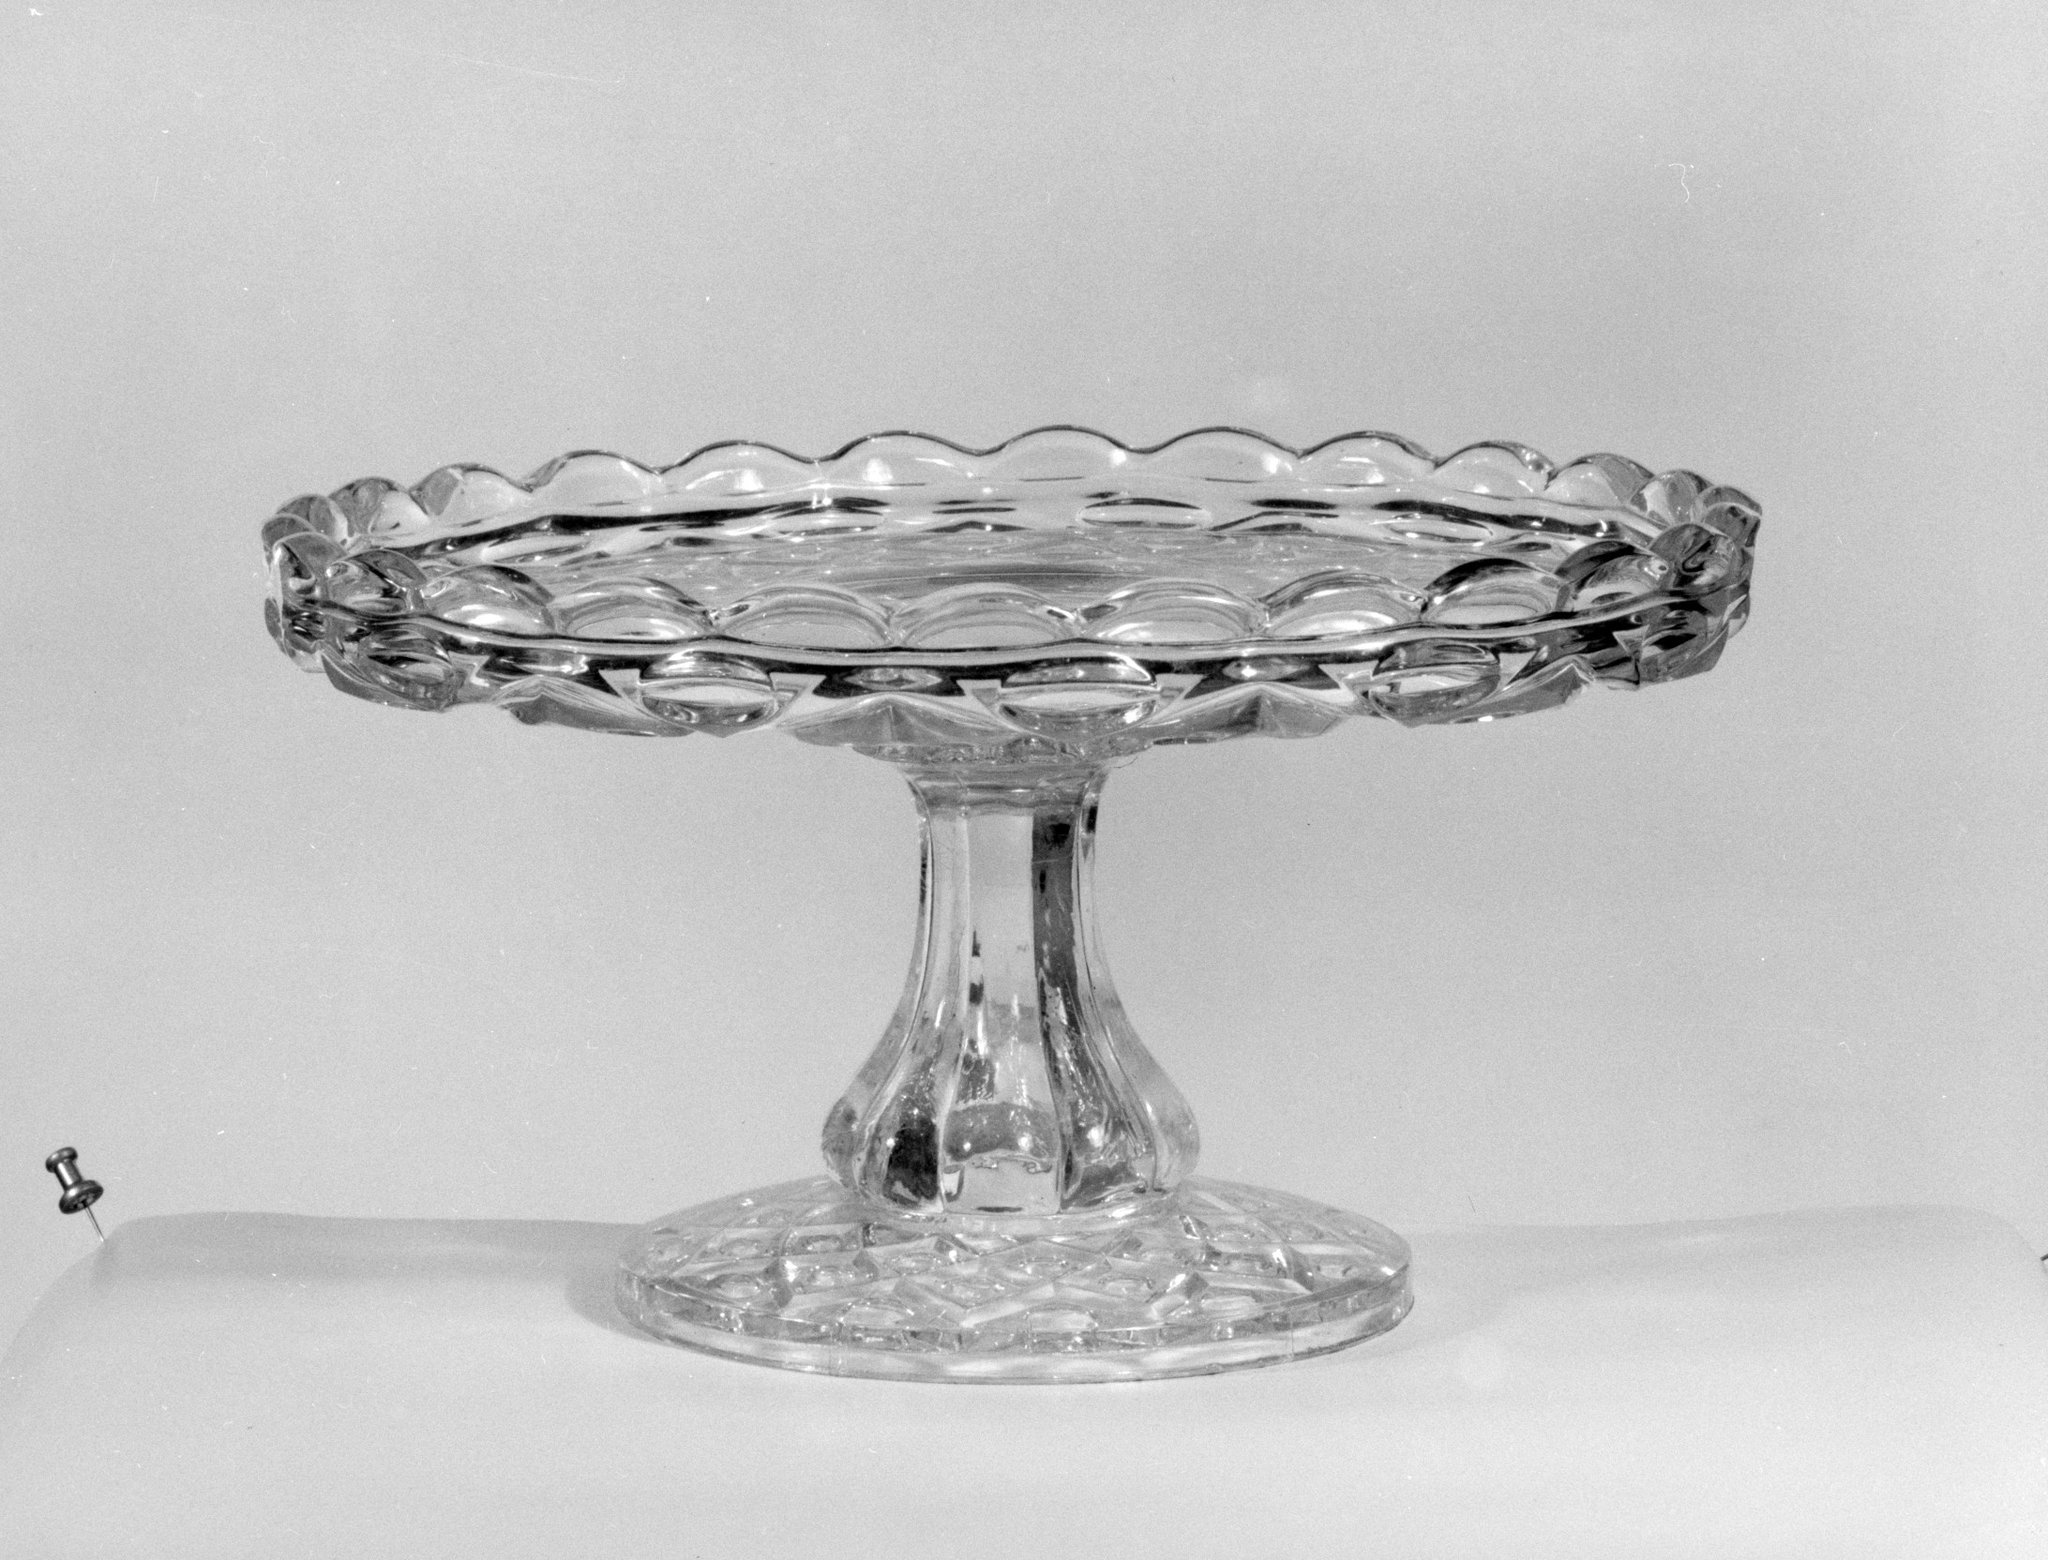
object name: cake plate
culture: american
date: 1800-1900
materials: diamond, glass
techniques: pressed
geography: united states